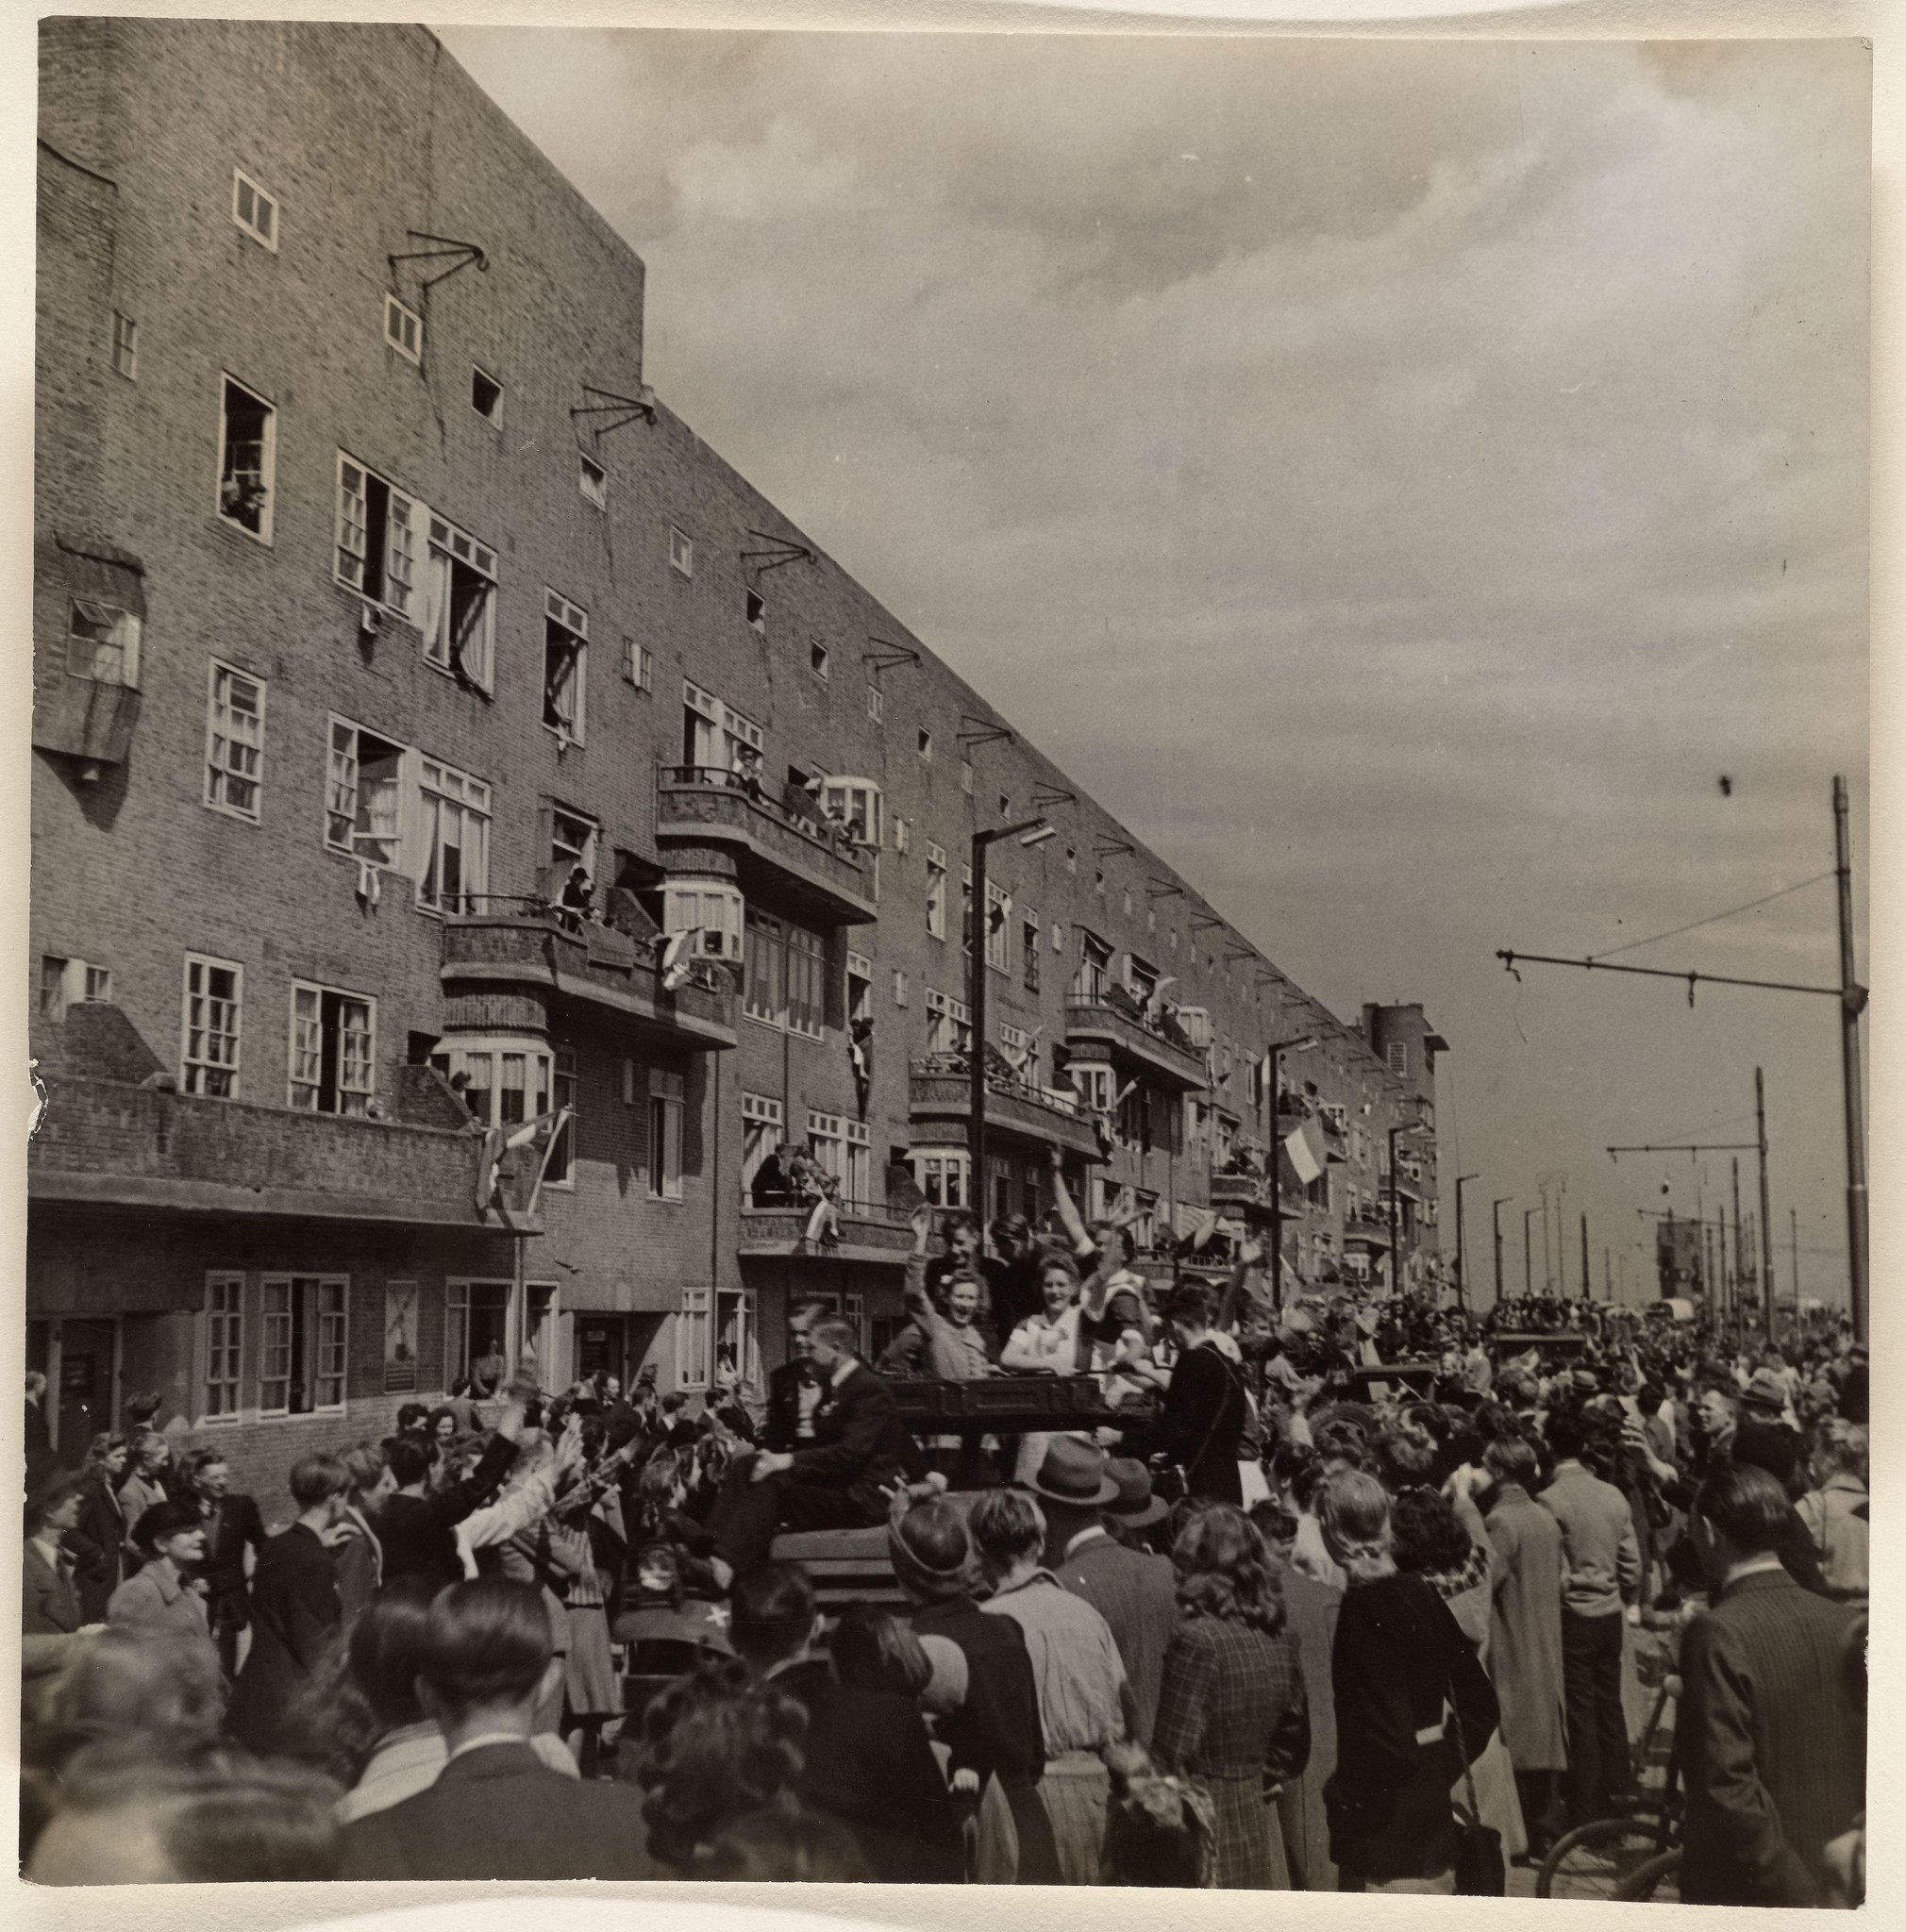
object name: photograph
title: Bevrijding Amsterdam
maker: willem van de poll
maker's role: fotograaf, journalist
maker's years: 1895-1970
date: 1905-1945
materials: photographic support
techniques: photography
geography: amsterdam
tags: amsterdam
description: Amsterdammers begroeten de Canadese bevrijders op de Zuider-Amstellaan (nu Vrijheidslaan) bij de Berlagebrug.